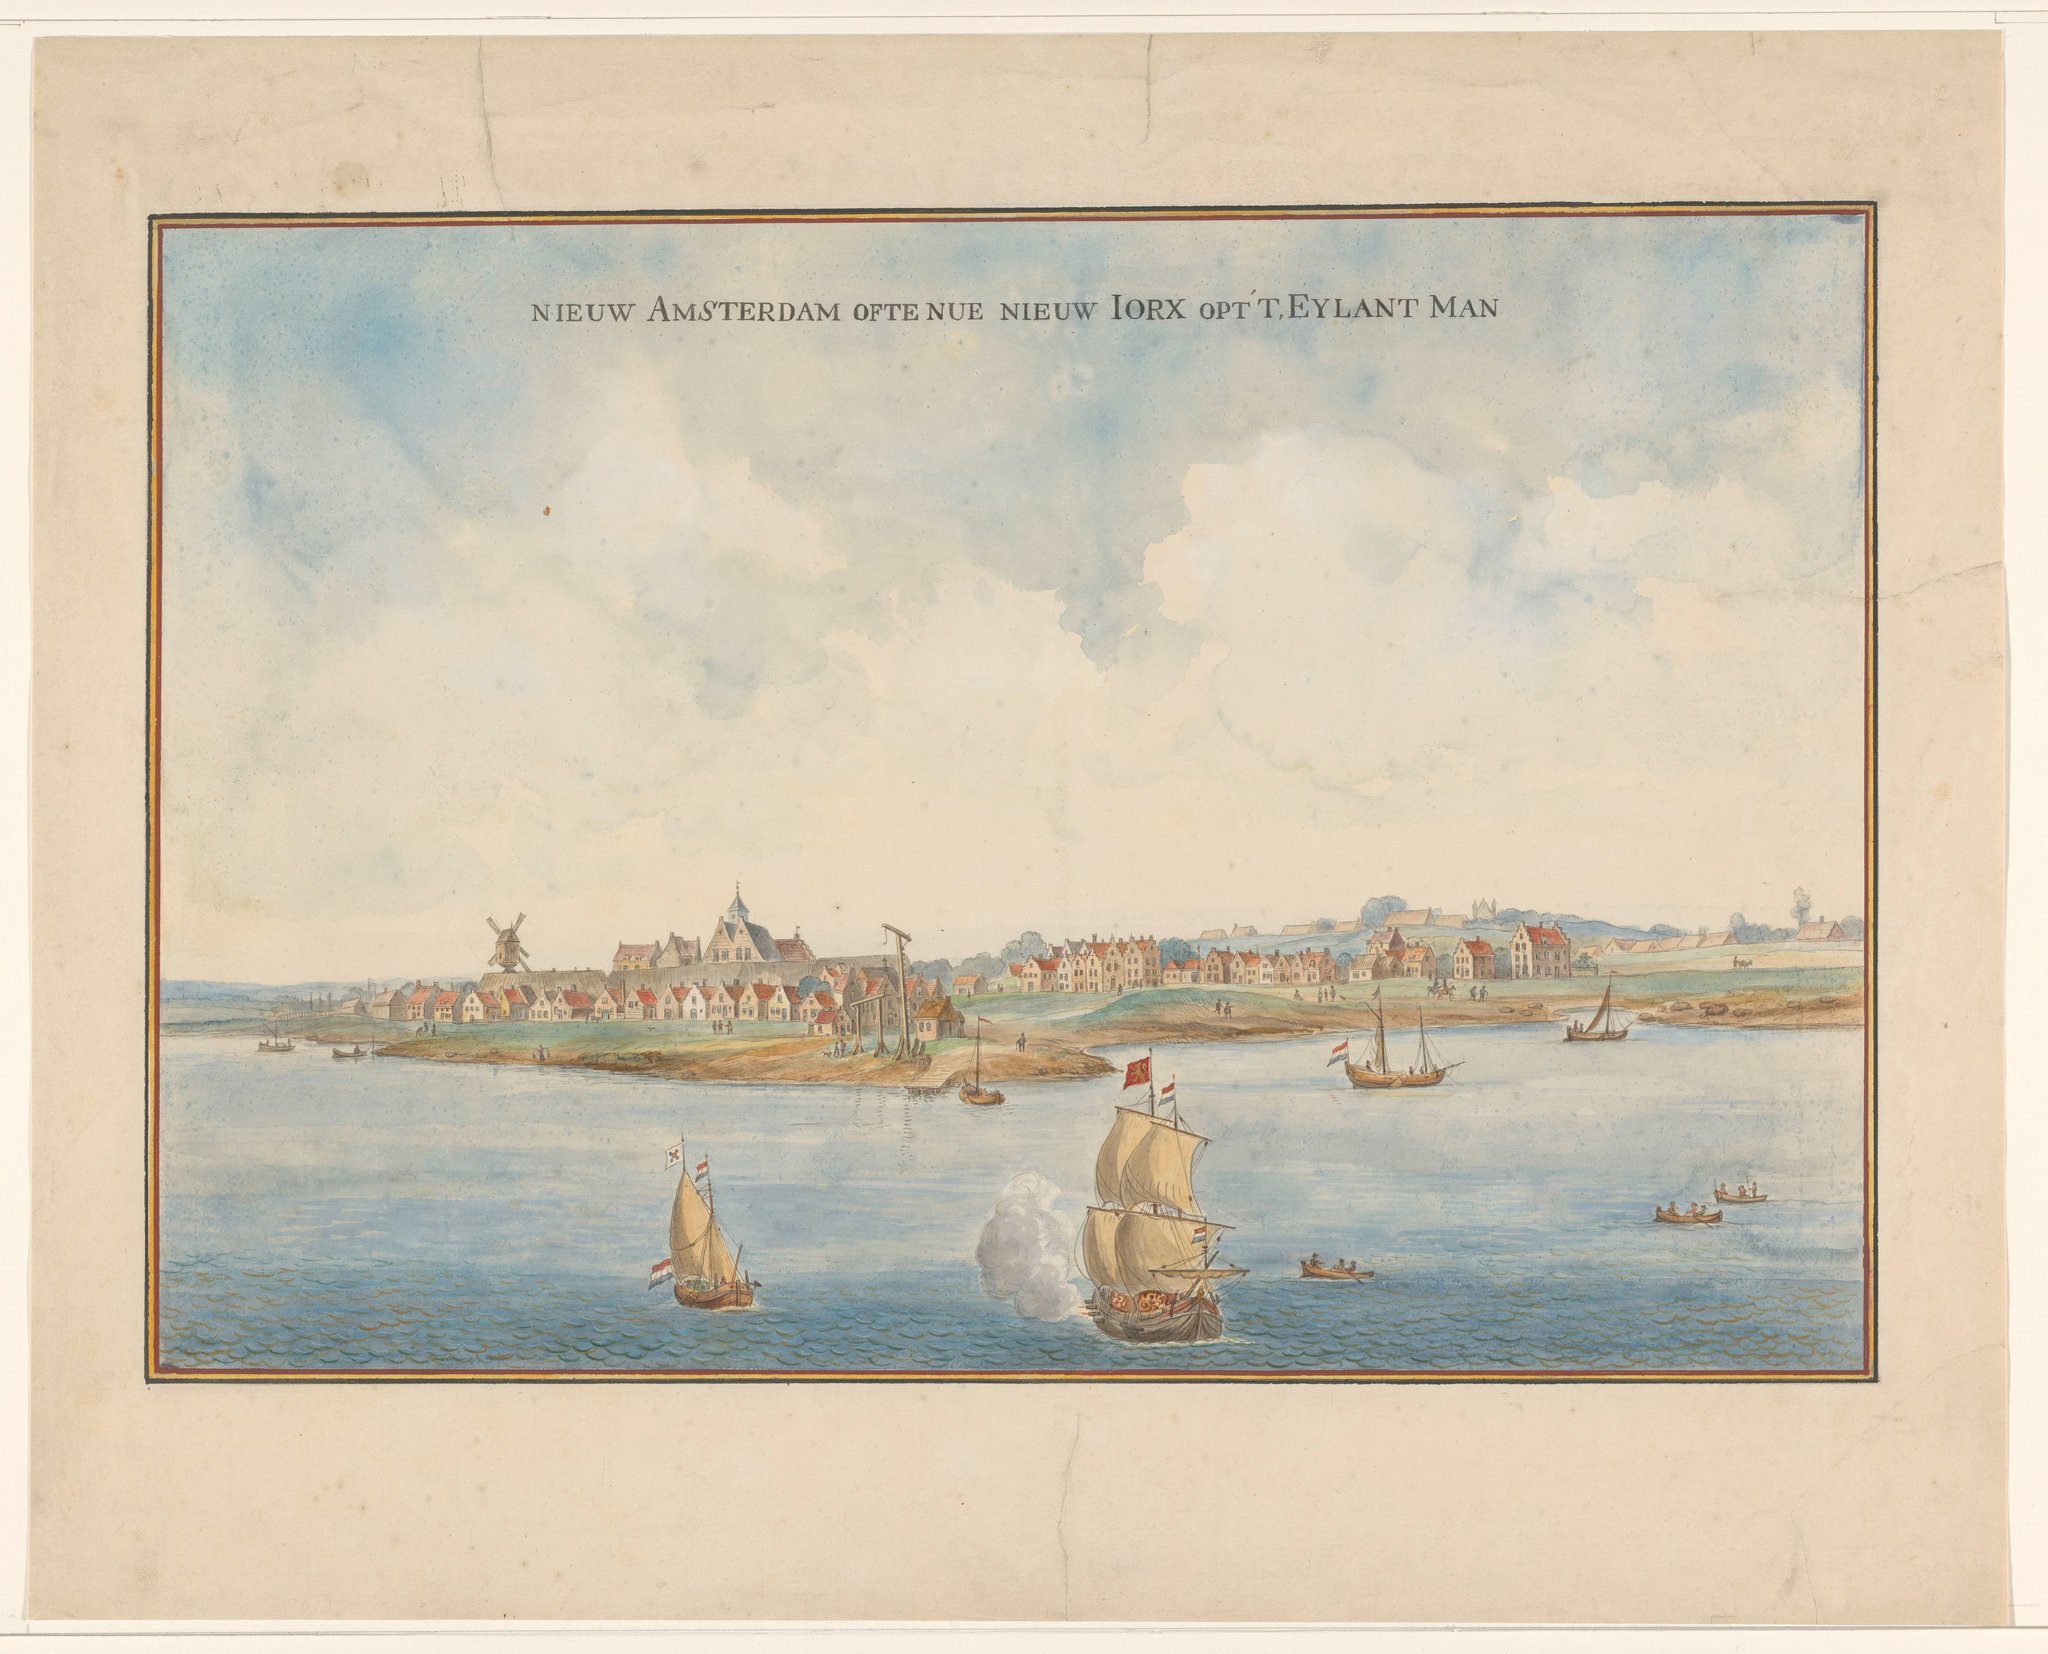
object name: drawing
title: Nieuw Amsterdam ofte nue Nieuw Iorx opt't Eylant Man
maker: Anonymous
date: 1660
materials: paper, watercolor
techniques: brush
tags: prospect of city, town panorama, silhouette of city - ii - ideal city, new york (city), manhattan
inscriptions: inscription: ‘NIEUW AMSTERDAM OFTE NUE NIEUW IORX OPT'T EYLANT MAN.’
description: Gezicht op kust van het eiland Manhattan vanaf de zee op de stad Nieuw Amsterdam of New York, onder grote bewolkte lucht. Op zee vier zeilschepen; de grootste lost schoten. Drie schepen met Nederlandse vlag, rechtsonder drie roeibootjes. Midden steiger met twee palen waarachter huizenrijen.